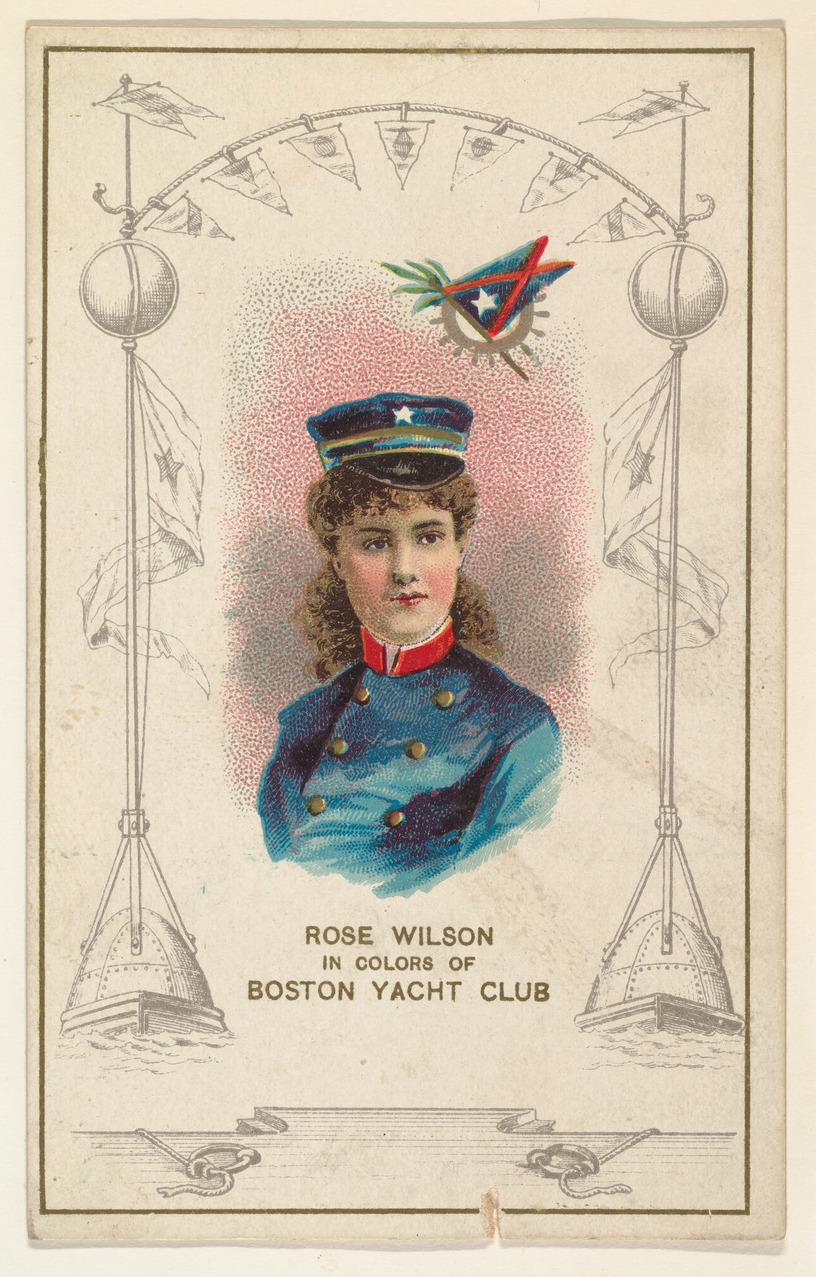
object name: print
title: Rose Wilson in Colors of the Boston Yacht Club, from the Yacht Colors of the World series (N140) issued by Duke Sons & Co. to promote Honest Long Cut Tobacco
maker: w. duke, sons & co.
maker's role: publisher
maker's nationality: american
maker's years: 1870-1920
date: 1890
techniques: color lithograph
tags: portraits,women,flags